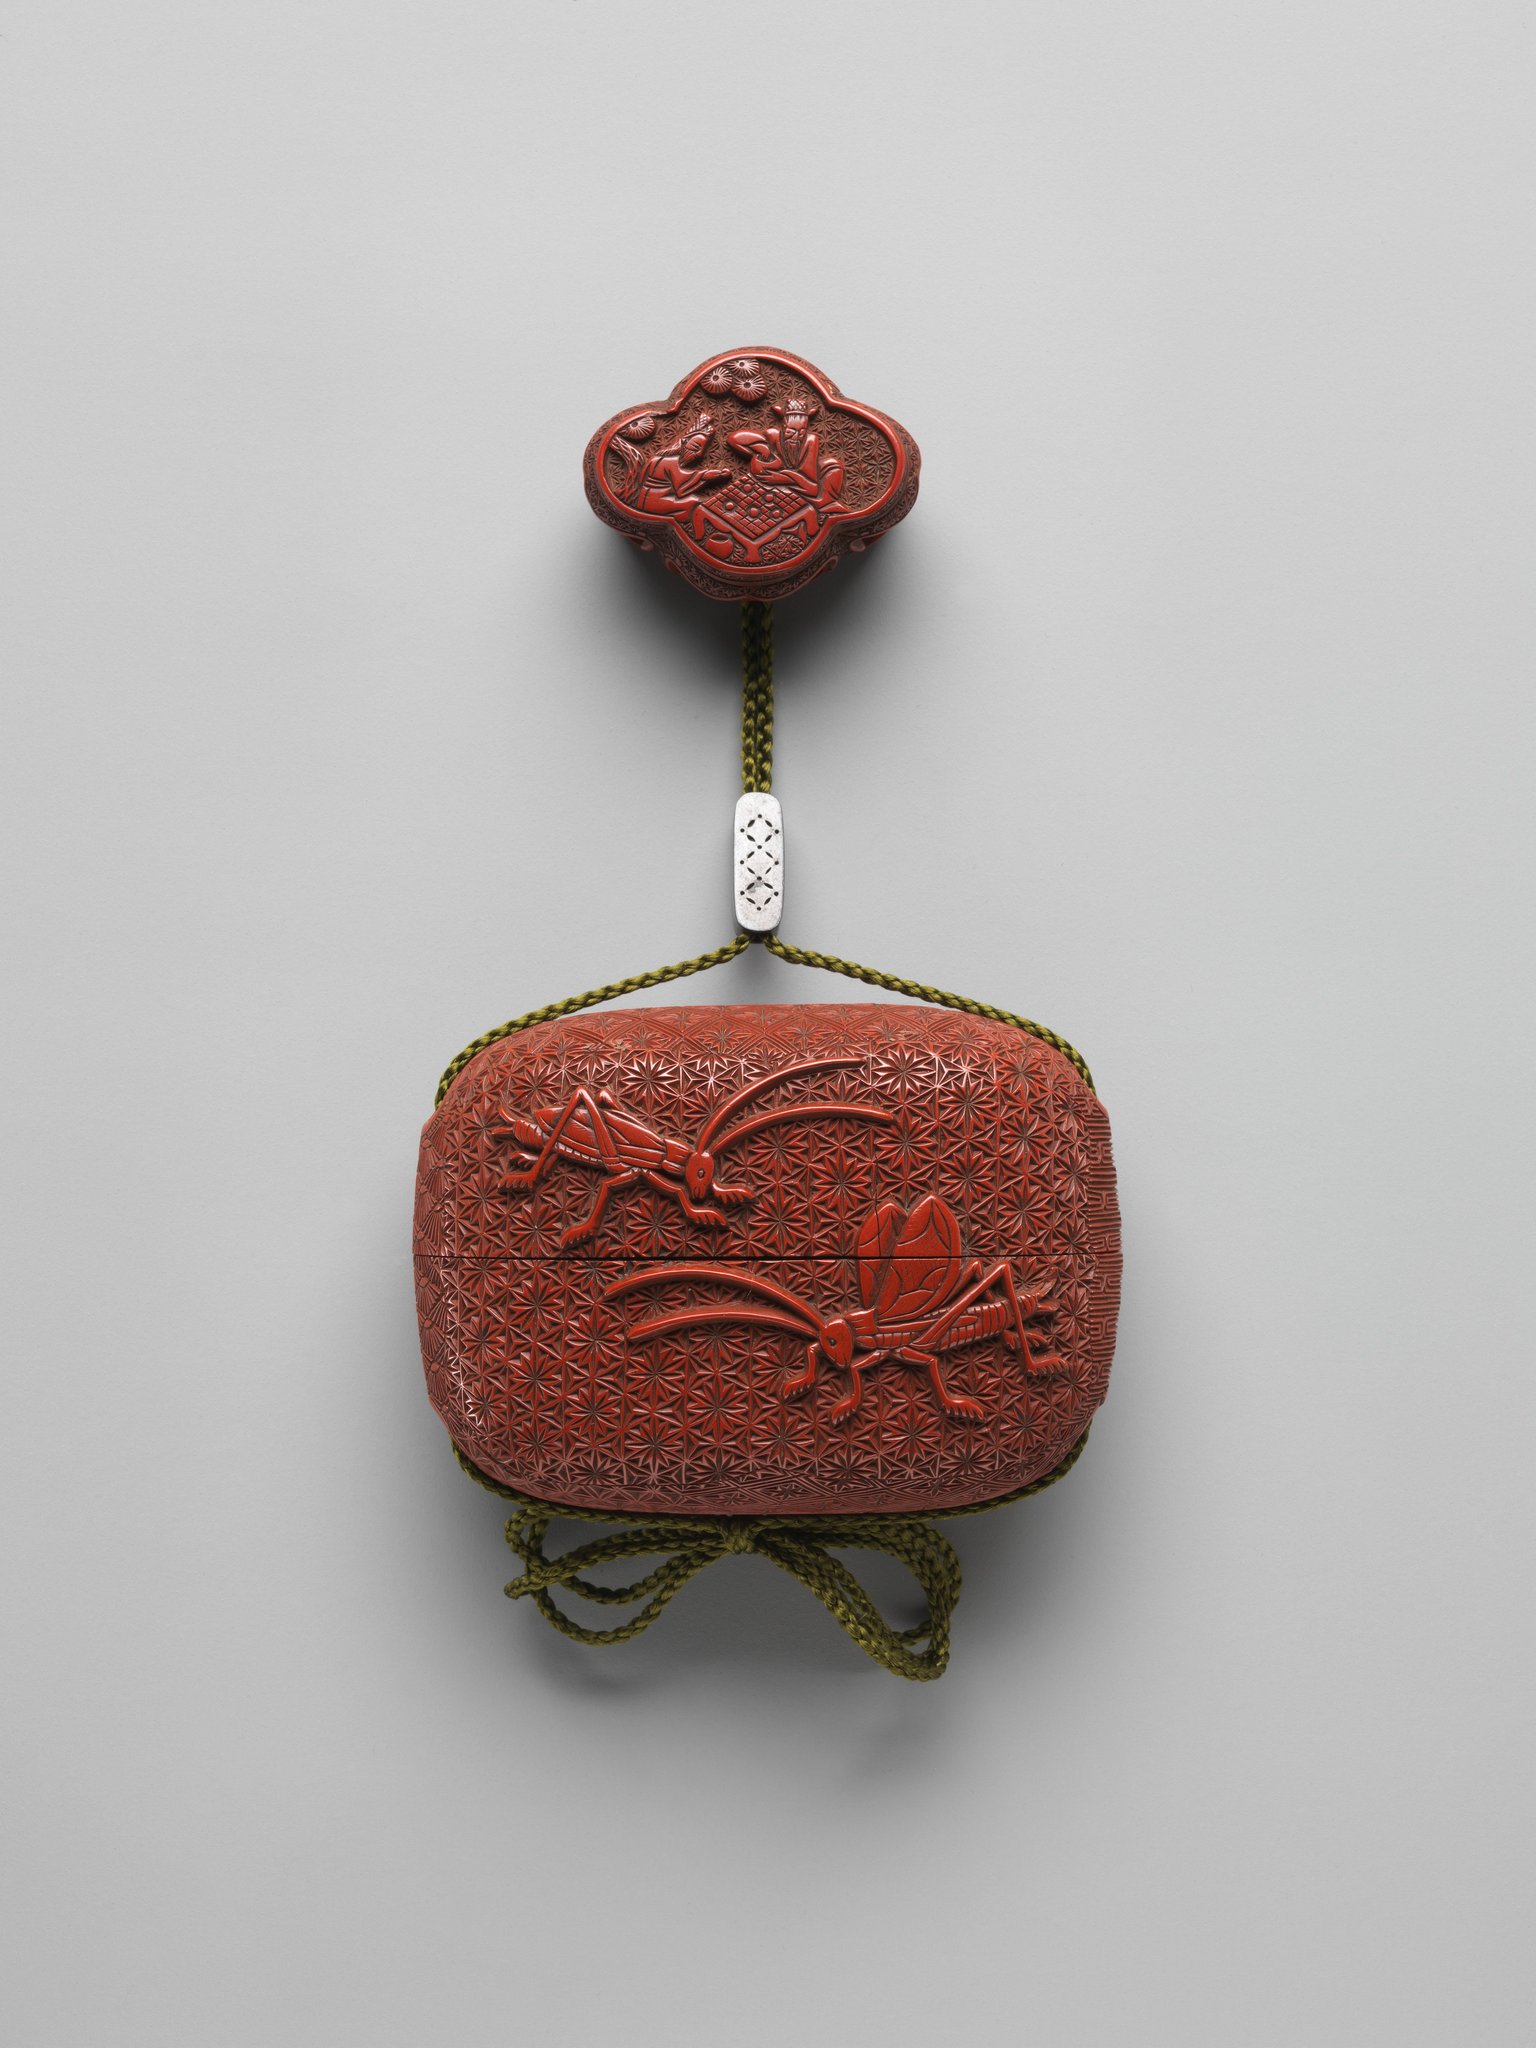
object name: inrō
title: Case (Inrō) with Design of Crickets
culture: japanese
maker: onko takanaga (dates unknown)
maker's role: artist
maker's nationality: japanese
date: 1801-1900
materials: lacquer, silver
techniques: carving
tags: men,insects,games